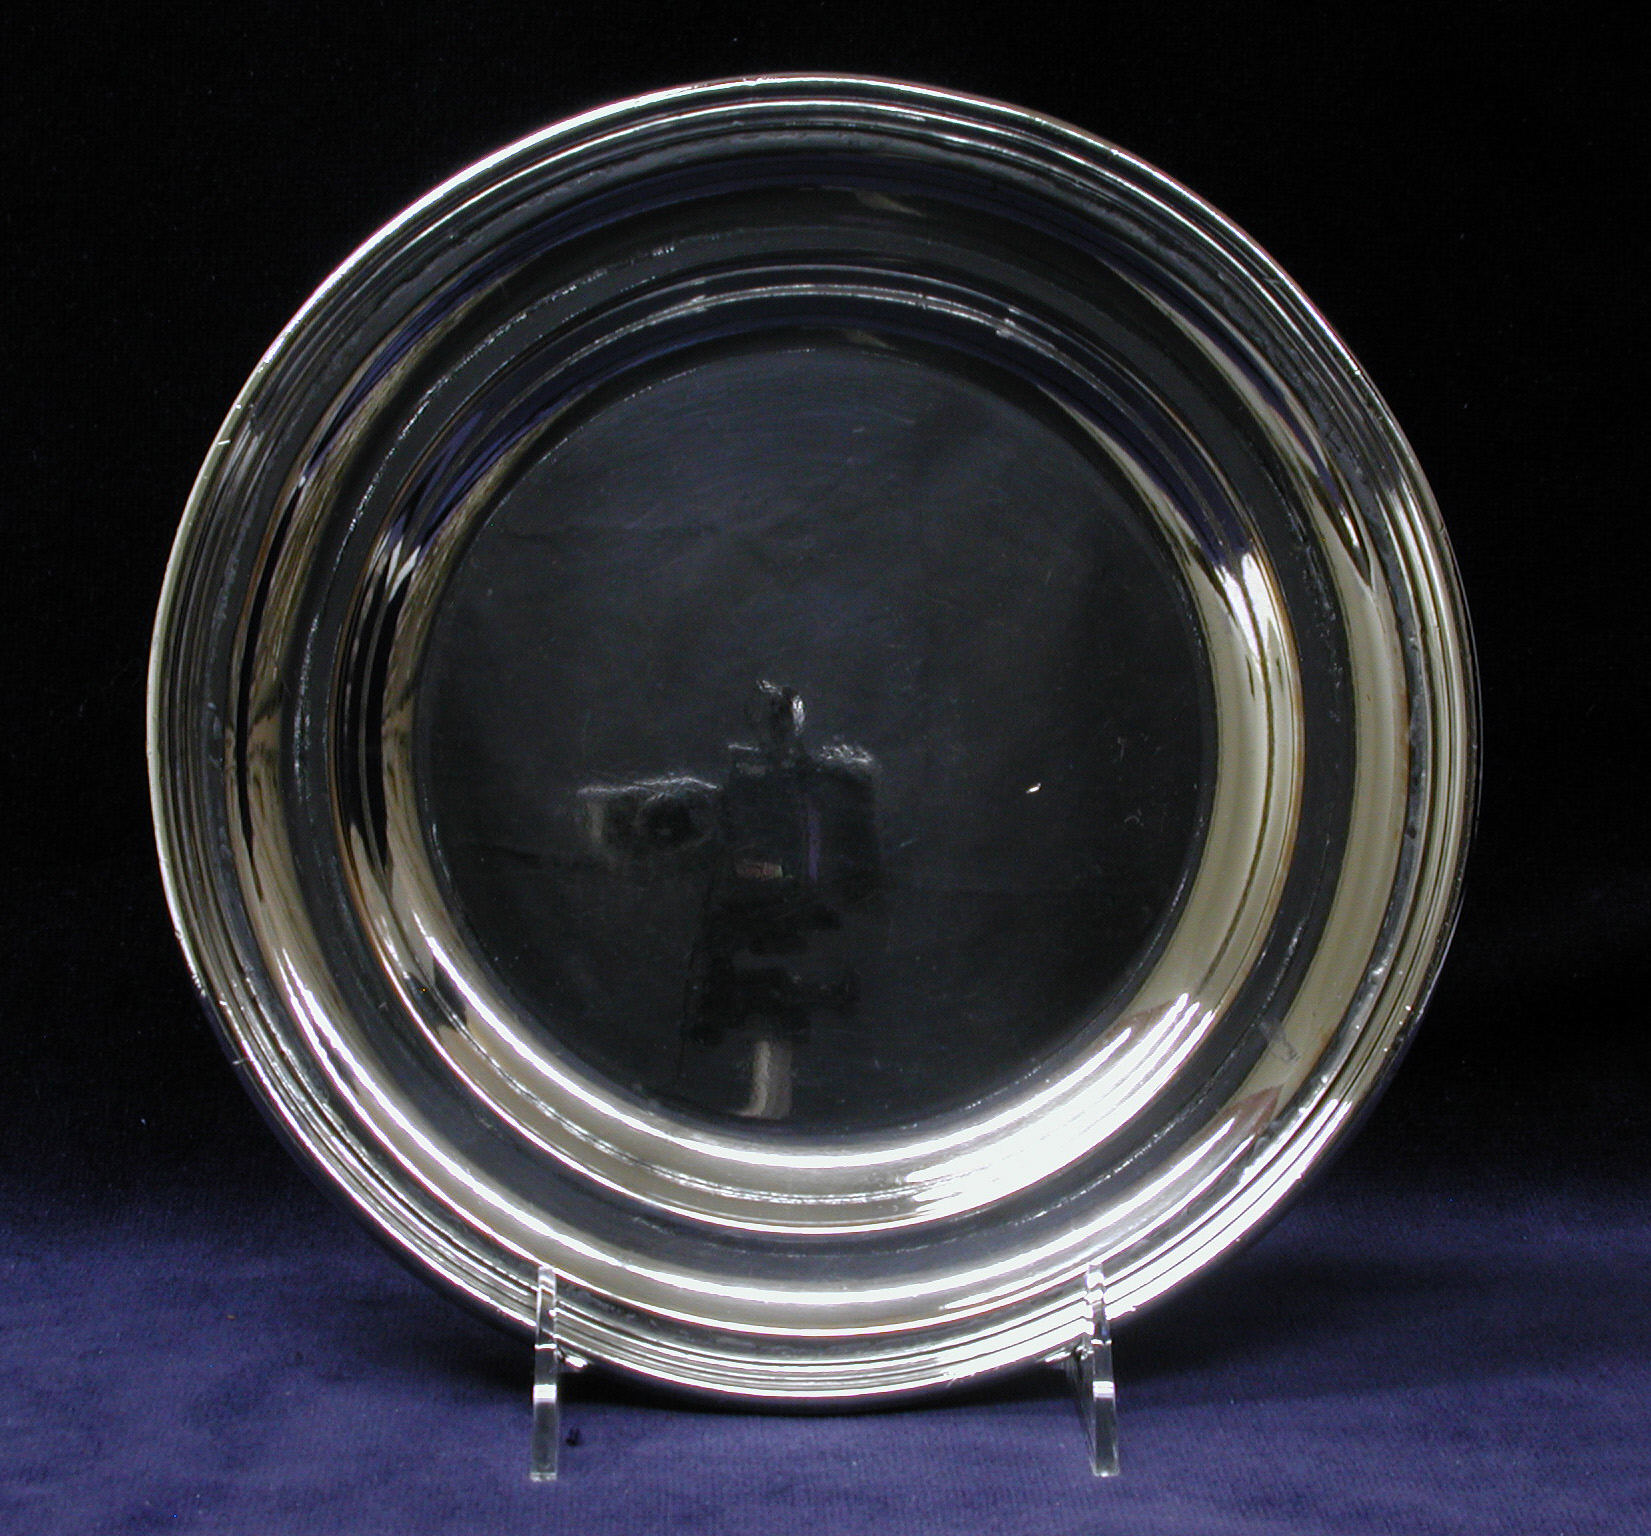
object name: plate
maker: james dixon & sons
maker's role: maker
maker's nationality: british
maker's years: 1806-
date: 1830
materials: copper, silver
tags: horses,lions,coat of arms